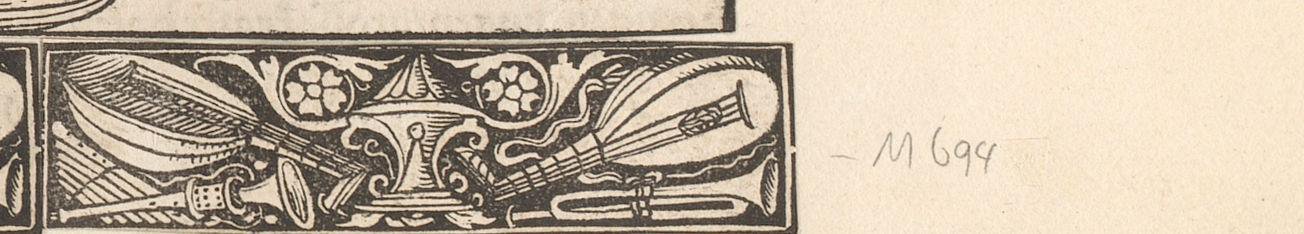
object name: album leaf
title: Vaas met aan weerszijden een luit en een trompet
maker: Anonymous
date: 1532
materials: paper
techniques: woodcut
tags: horn, trumpet, cornet, trombone, tuba, vase ~ ornament, lute, and special forms of lute, e.g.: theorbo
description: Deze prent is gebruikt als ornament in: Petrarca, Francesco. Von der Artzney bayder Glück, des guten und widerwertigen: unnd weß sich ain yeder inn Gelück und Unglück halten sol (...). Augsburg: Heinrich Steiner, 1532. Deze uitgave is ook bekend onder de titel 'Trostspiegel in Glück und Unglück'.